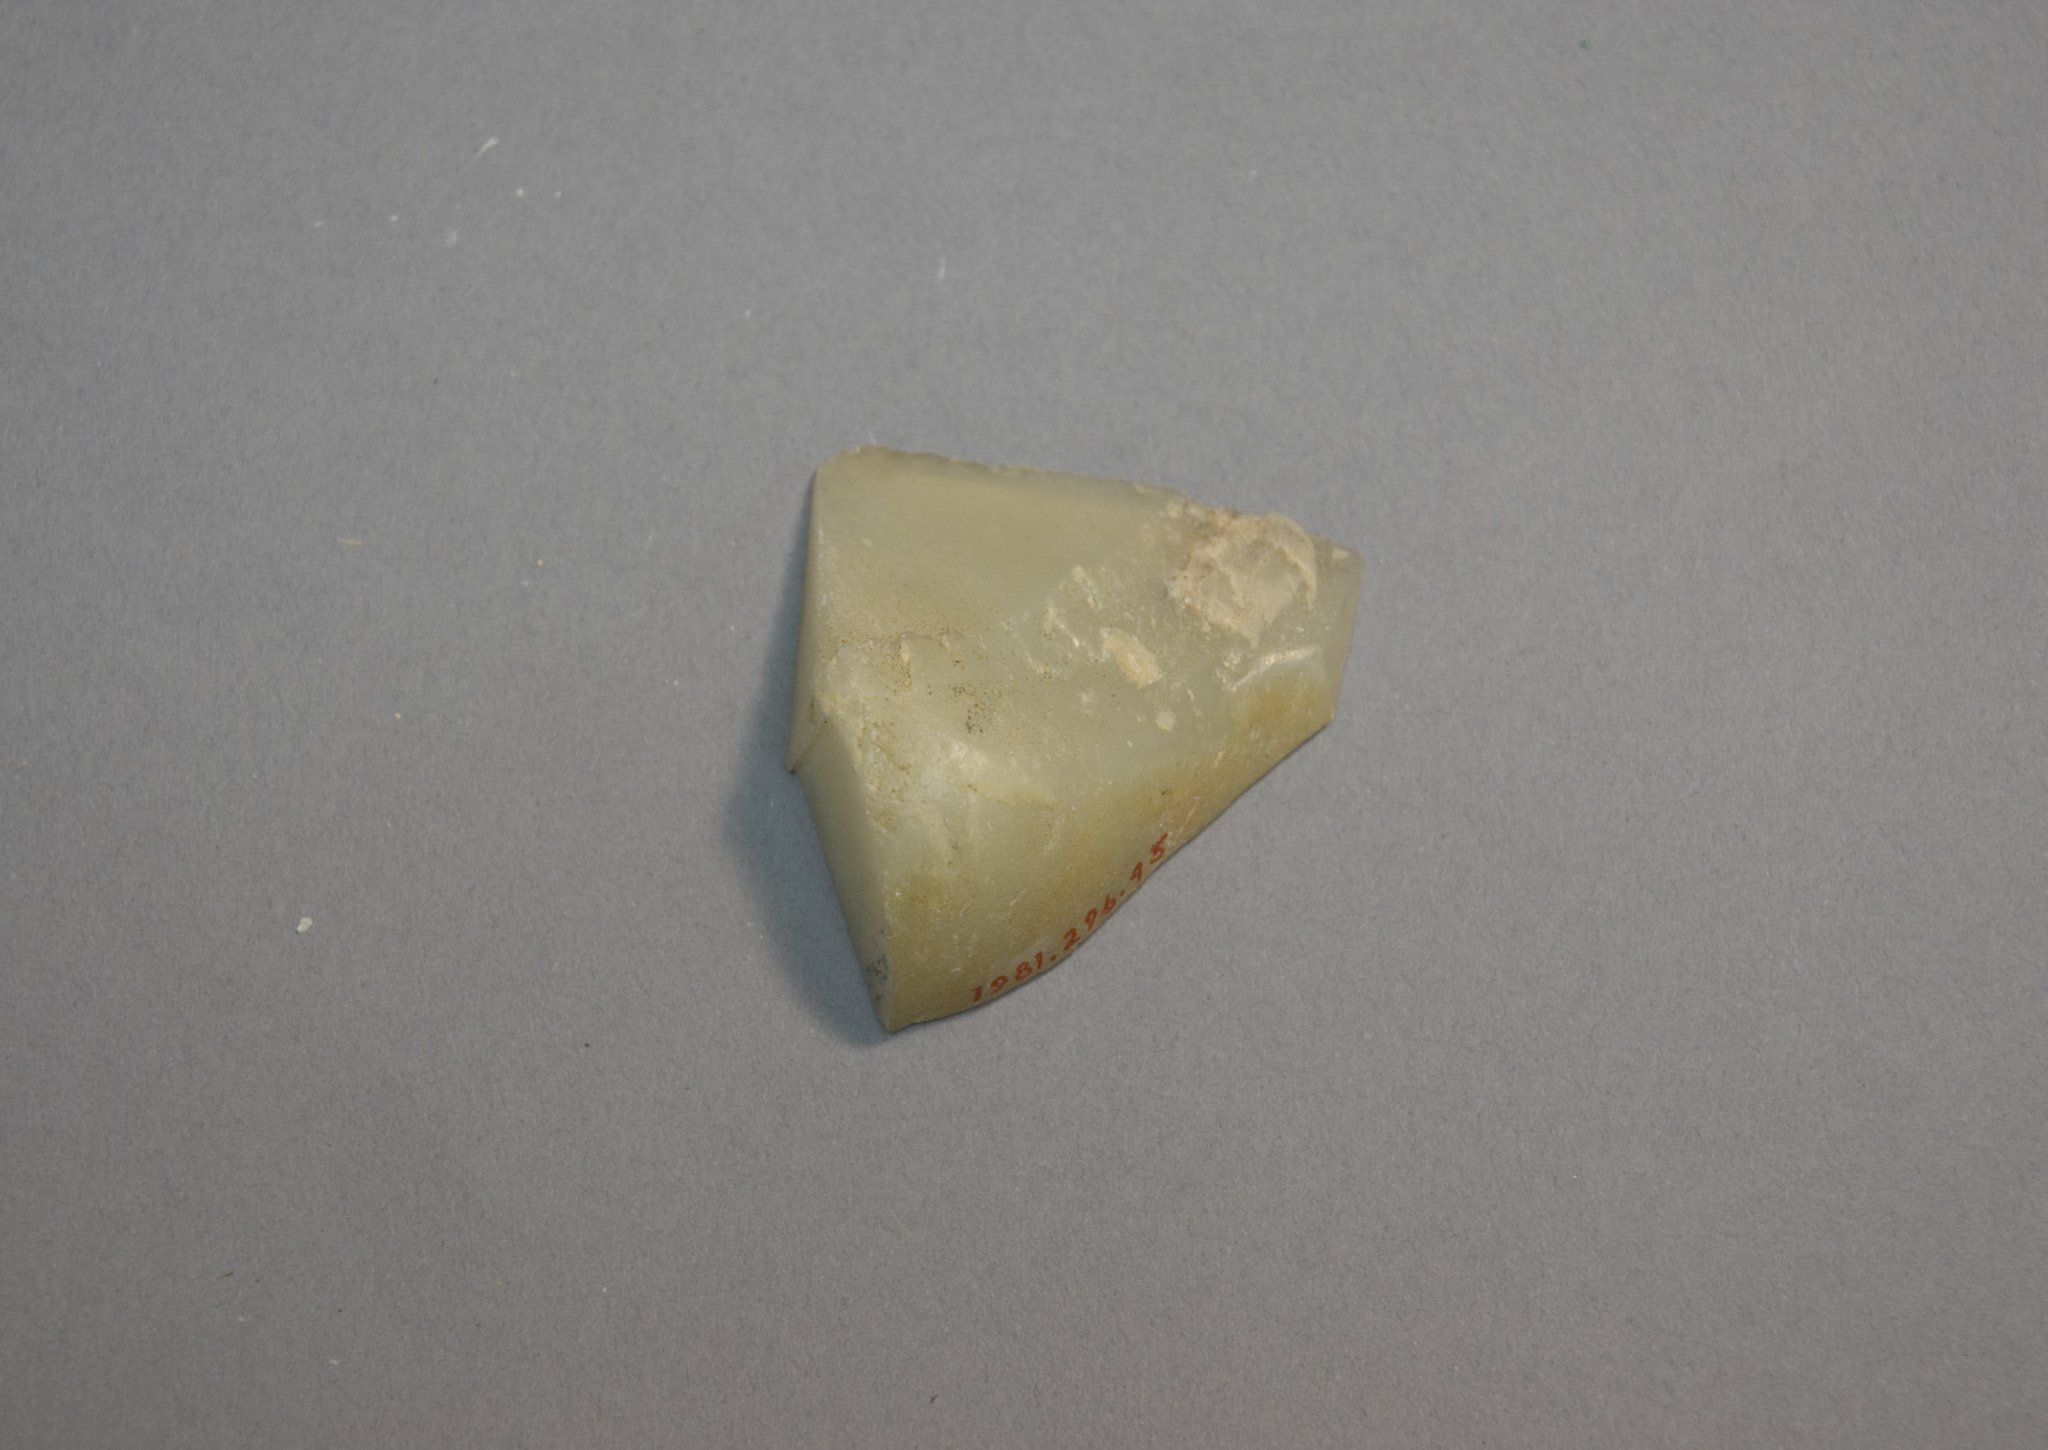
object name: jade carving material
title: Sample of Sinkiang White Nephrite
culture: chinese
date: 1901-2000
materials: jade